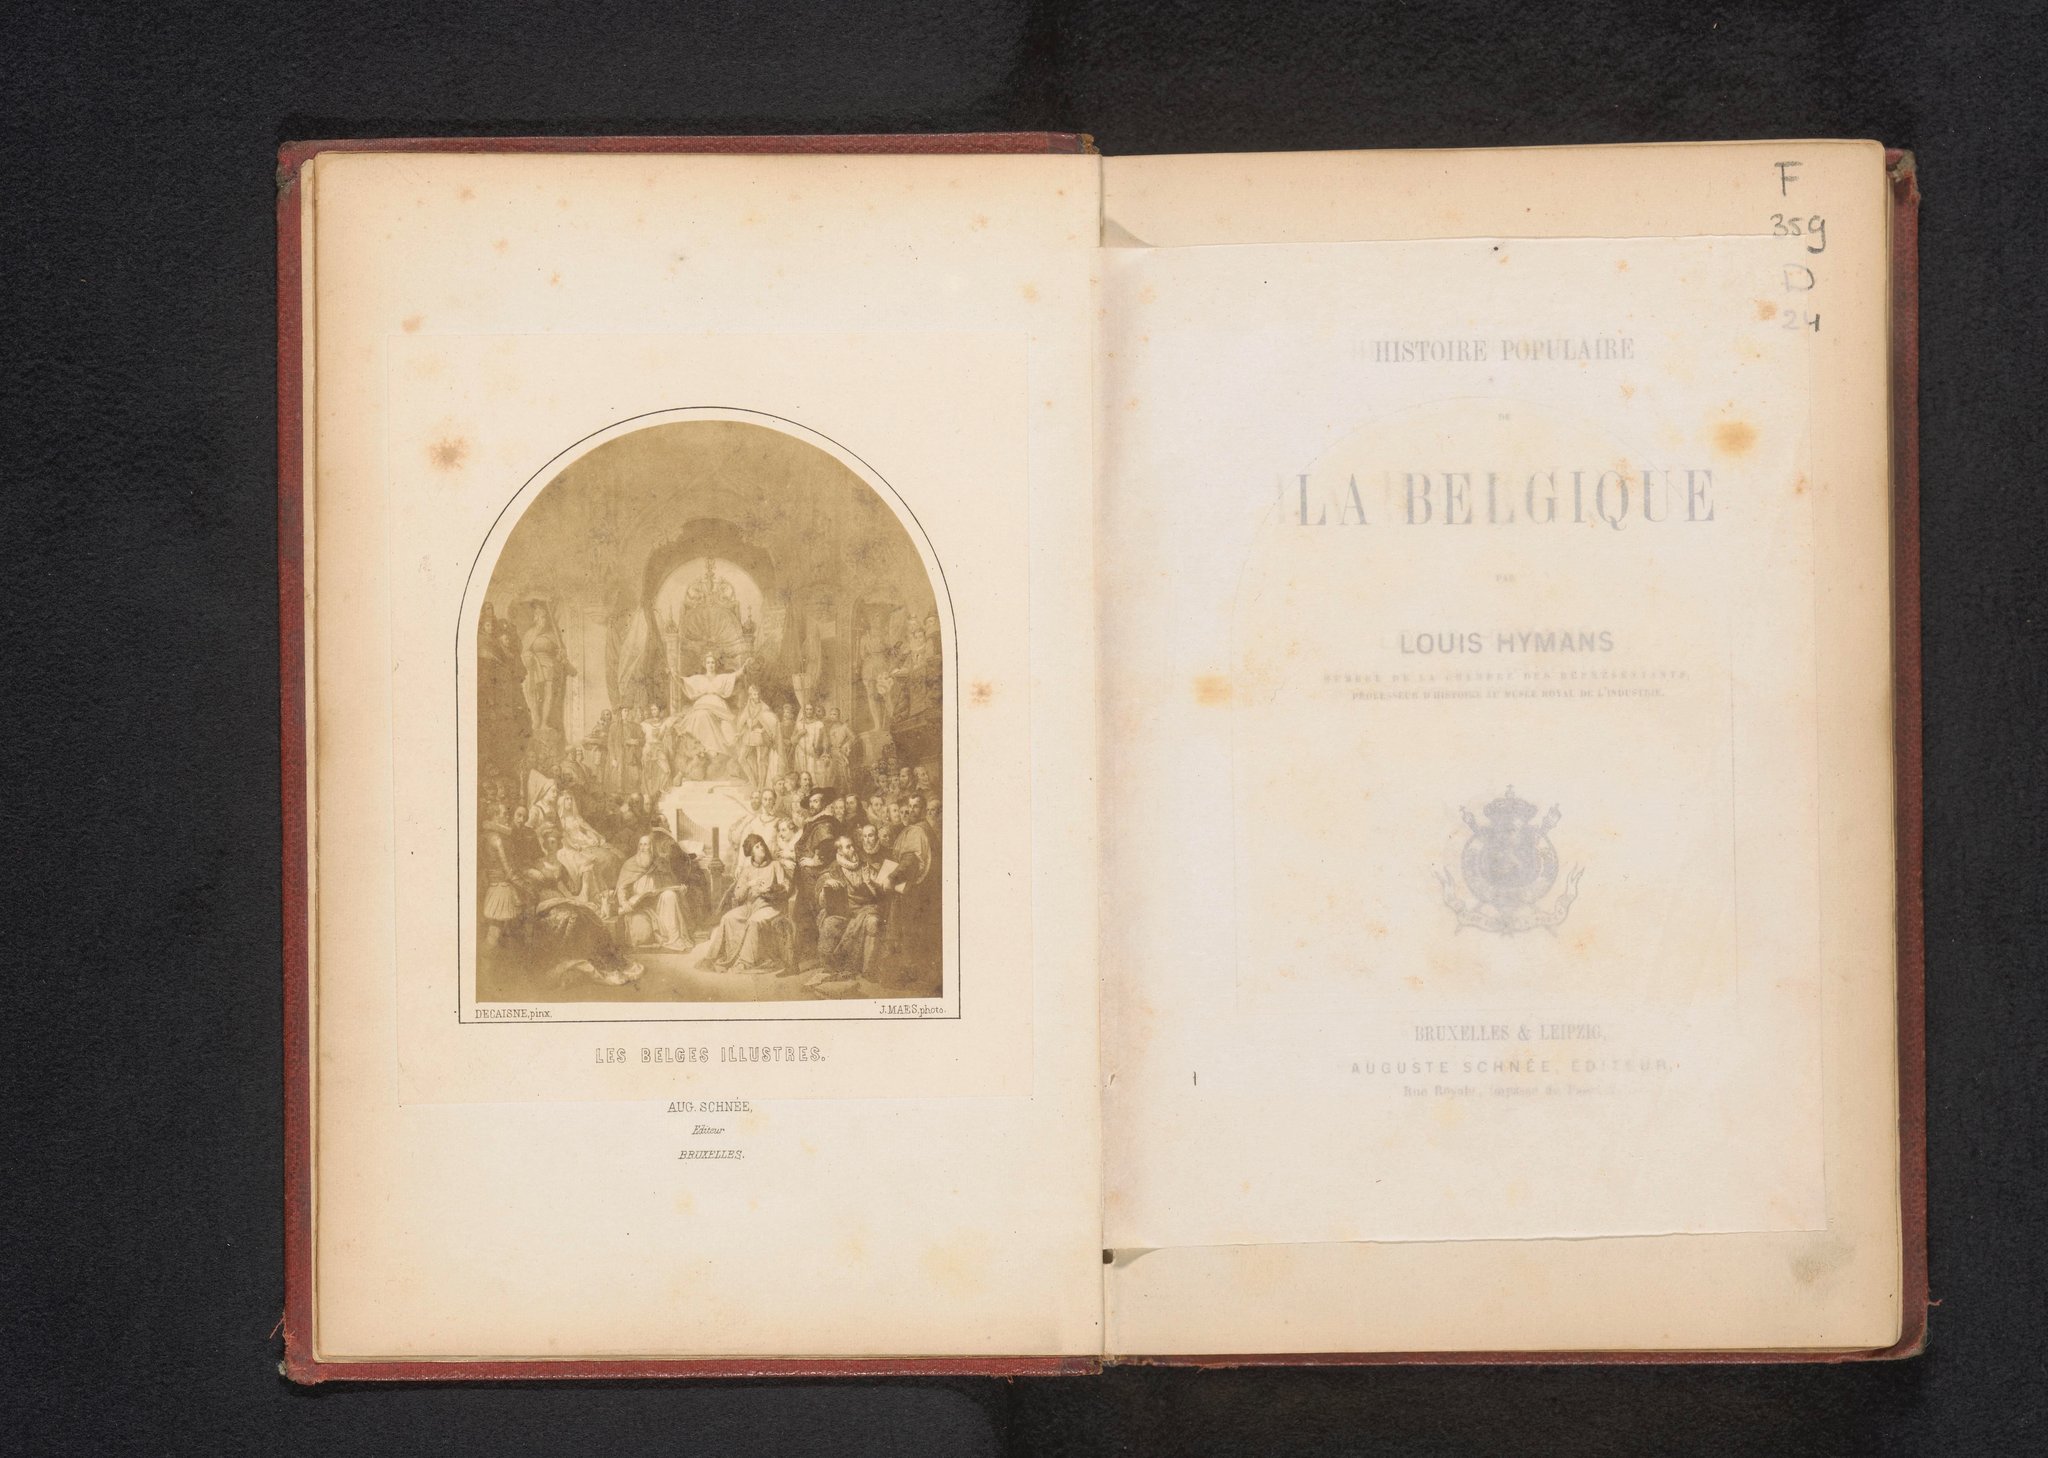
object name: photograph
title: Fotoreproductie van België kroont haar beroemde kinderen door Henri Decaisne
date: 1855-1860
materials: photographic support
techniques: albumen print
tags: anonymous historical persons portrayed in a group, in a group-portrait